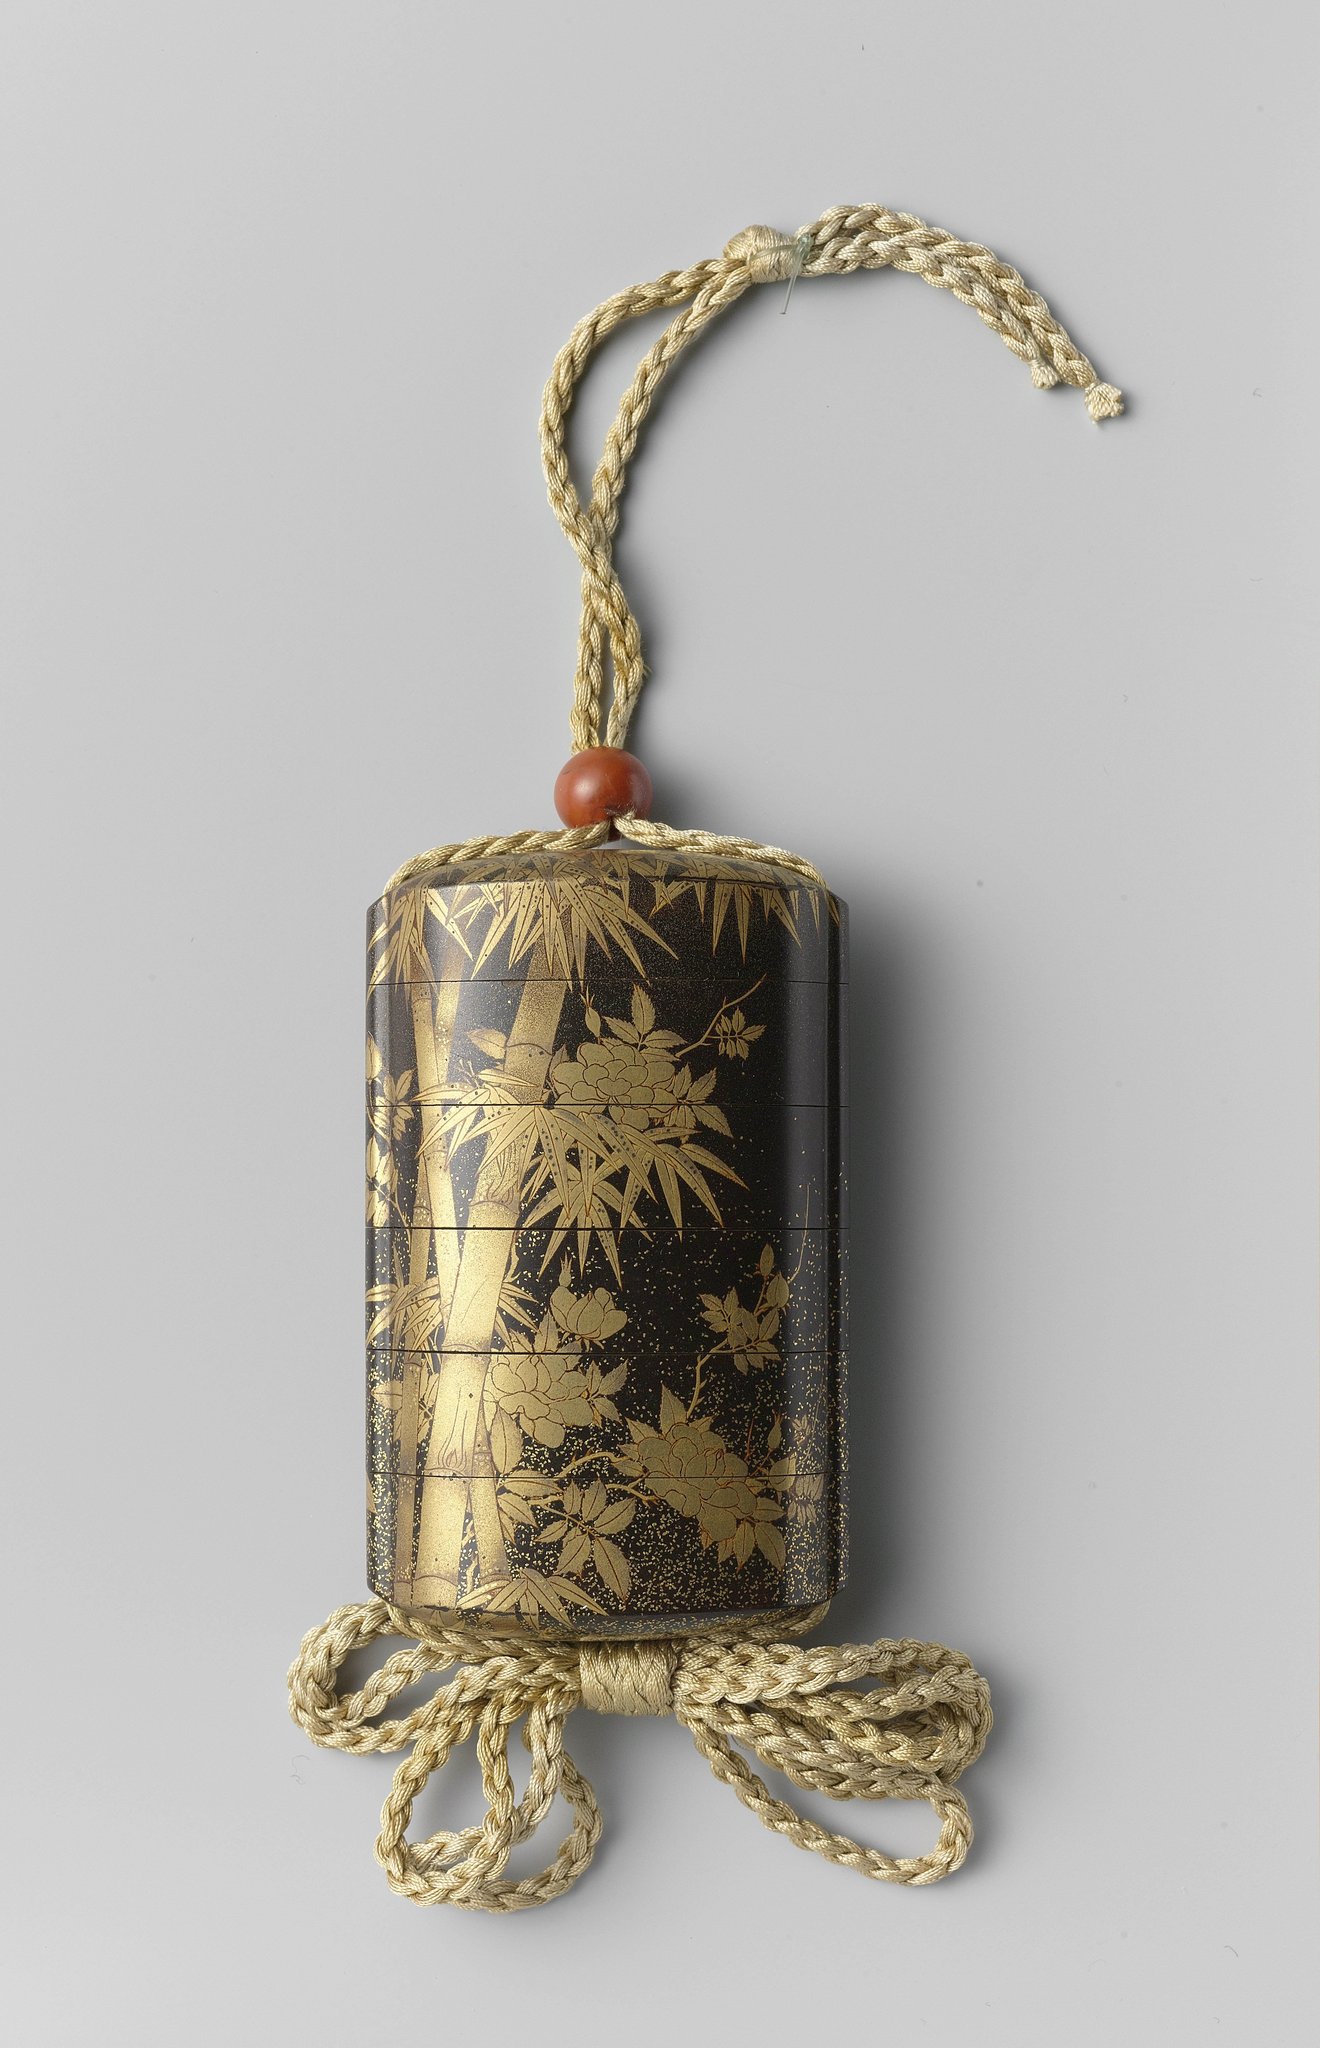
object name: inrō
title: Inro (seal case)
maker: Anonymous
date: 1700-1800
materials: lacquer, wood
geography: japan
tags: plants (in general)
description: Versiering van bamboe en pioenrozen in goud tegen zwart fond, fijn en grof gespikkeld in goud. Zes doosjes bij elkaar gehouden door een koord.